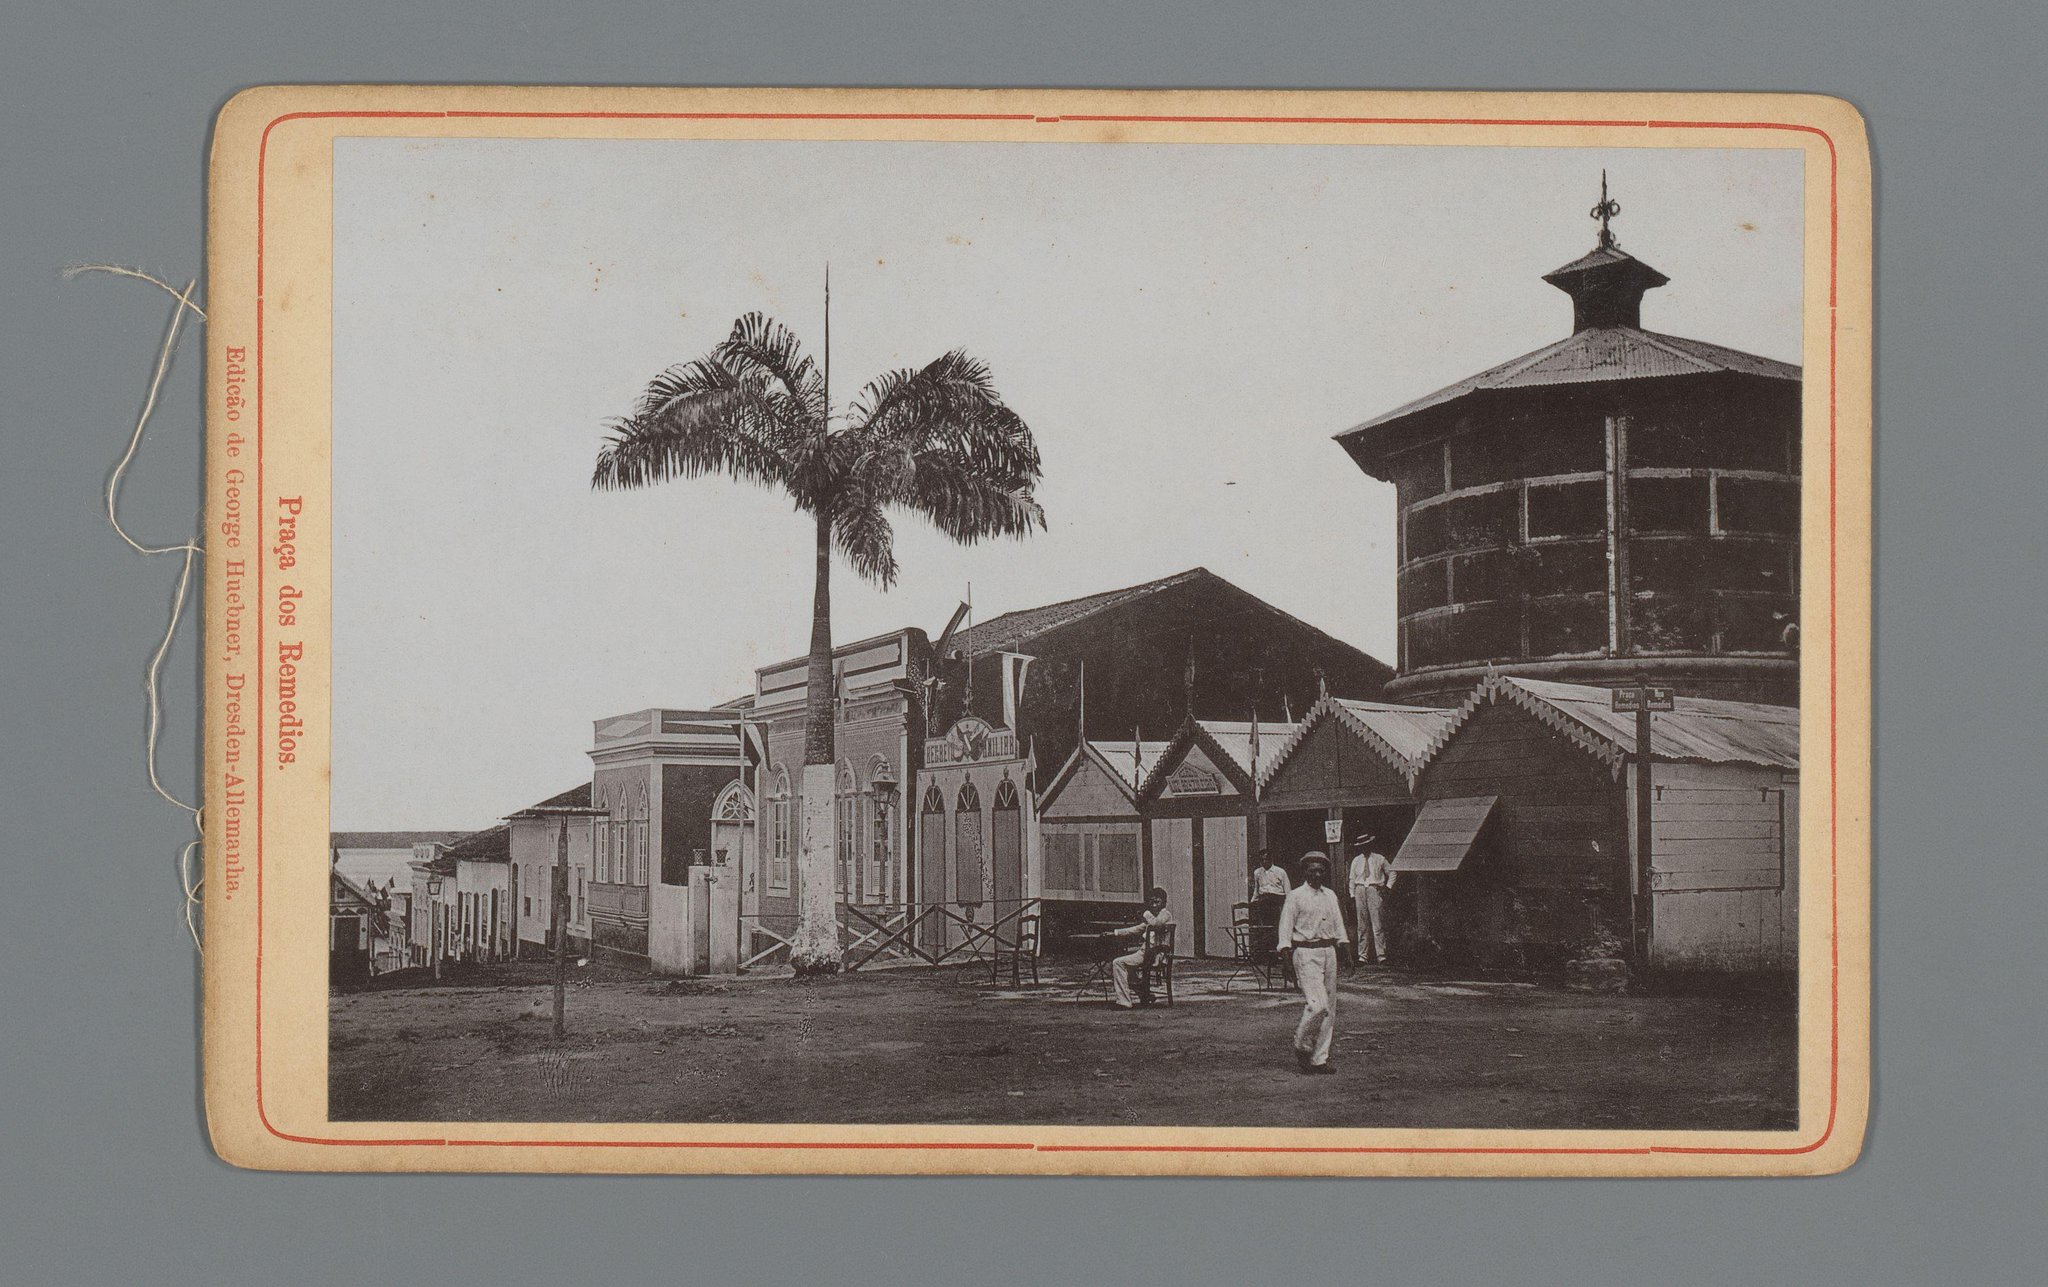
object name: cabinet photograph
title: Gezicht op het Praça dos Remédios in Manaus, Brazilië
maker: george huebner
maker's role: fotograaf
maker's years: 1862-1935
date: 1898-1935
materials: paper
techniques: gelatin silver print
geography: manaus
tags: village square, place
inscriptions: inscription: ‘Edicão de George Huebner, Dresden-Allemanha.’